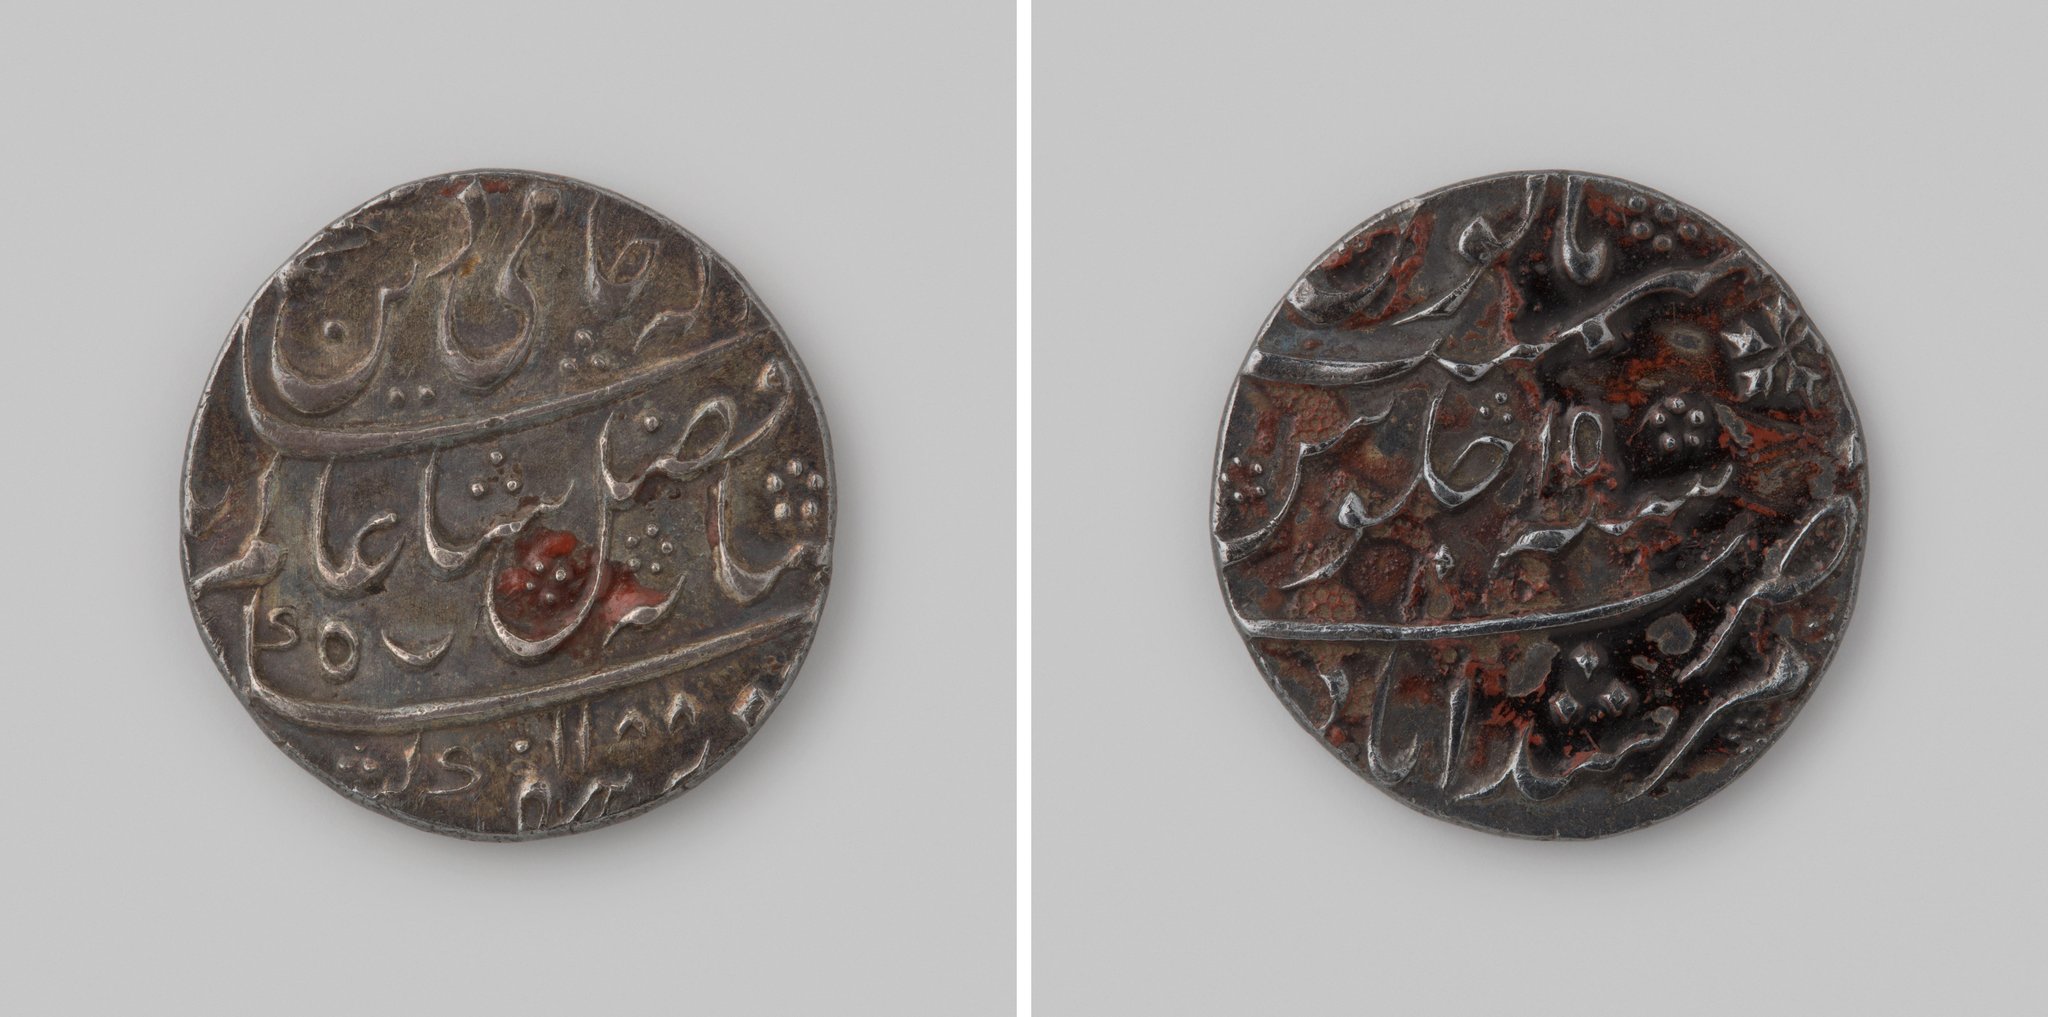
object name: coin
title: India, sjah Alam II, ½ roepie, 1188 [=1774], geslagen te Murshidabad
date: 1774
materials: silver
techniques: striking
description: Zilveren munt. Voorzijde: in Arabische lettertekens in drie regels opschrift. Onderaan jaartal: 1188. Keerzijde: in Arabische lettertekens in vier regels opschrift met aanduiding regeringsjaar 15 [=1188] en aanduiding muntplaats: Murshidabad.